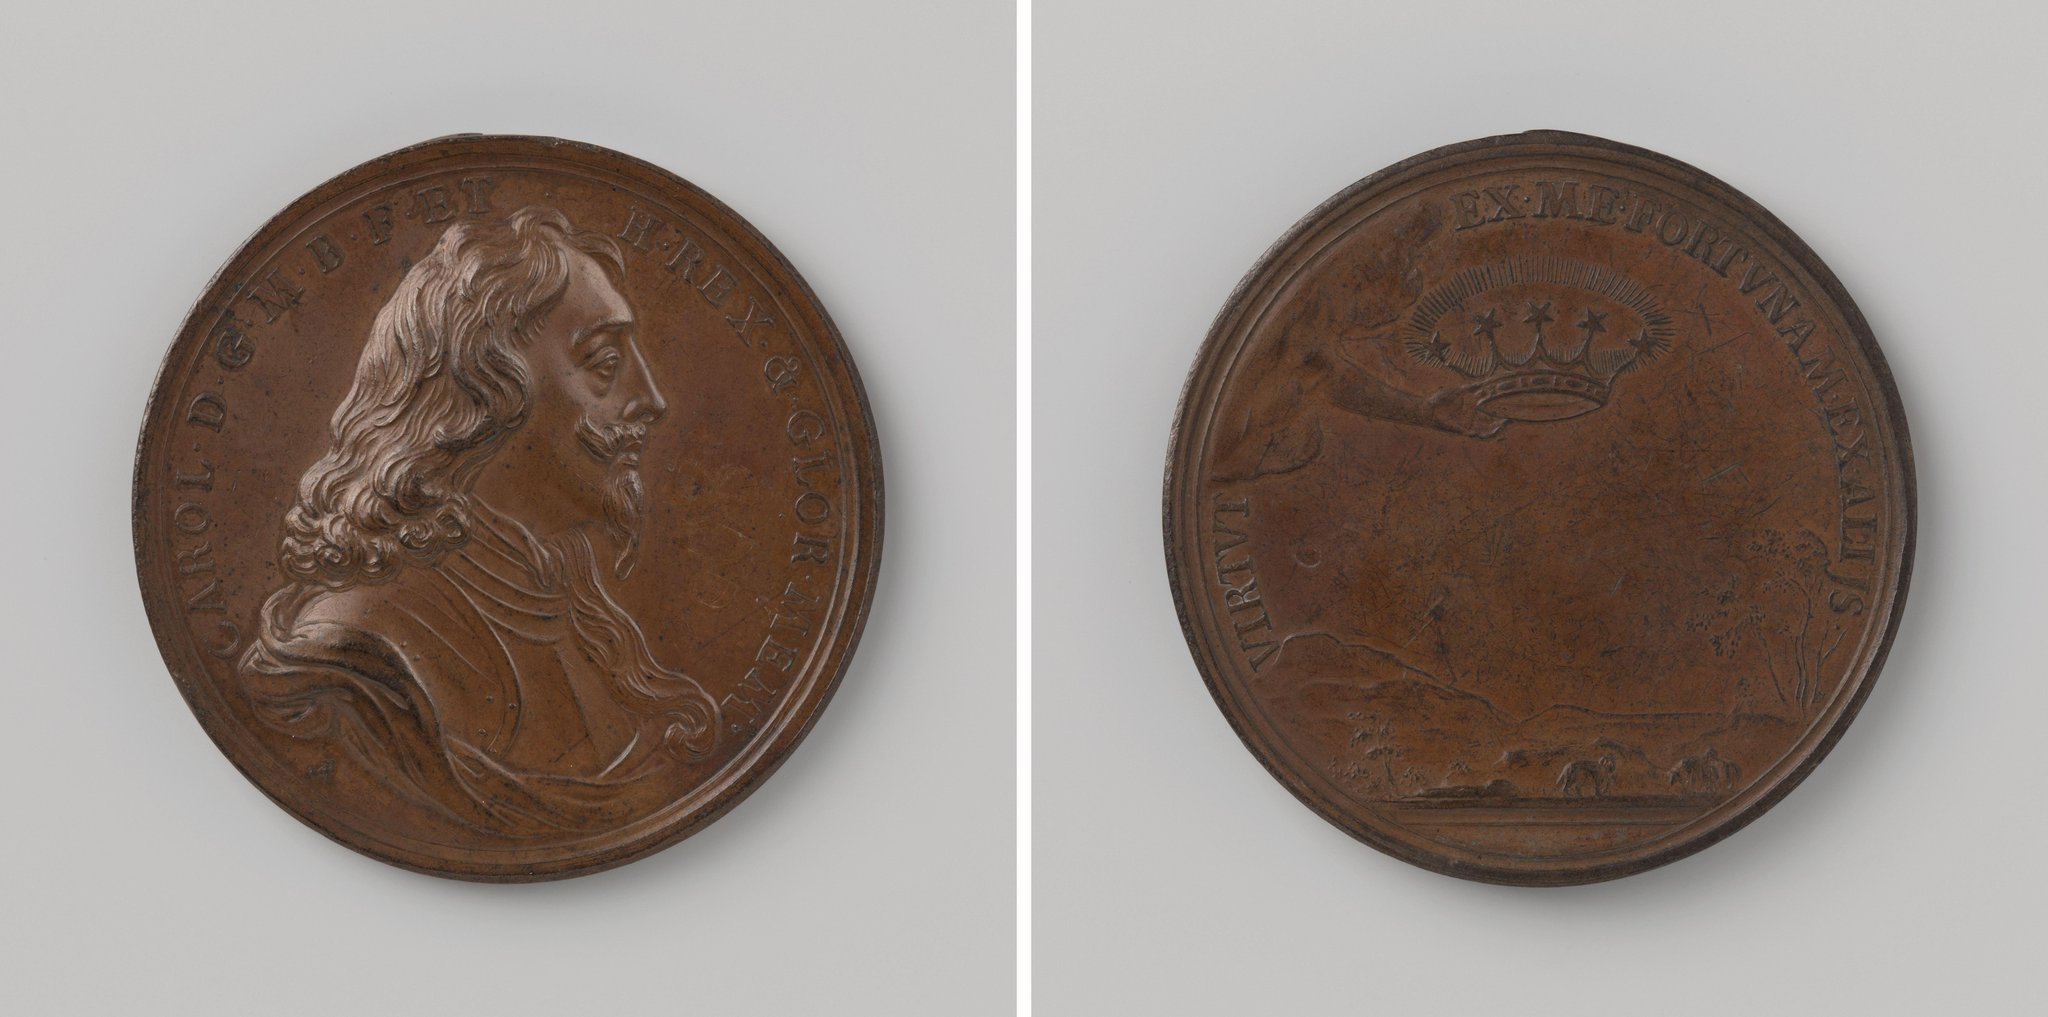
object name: copy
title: Karel I van Engeland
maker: jean roëttiers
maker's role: medailleur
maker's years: 1631-1703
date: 1660-1697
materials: bronze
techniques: striking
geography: london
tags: london, karel i (koning van engeland)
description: Bronzen penning. Voorzijde: borststuk man binnen omschrift. Keerzijde: hand uit wolken met kroon; op achtergrond grazende schapen binnen omschrift.